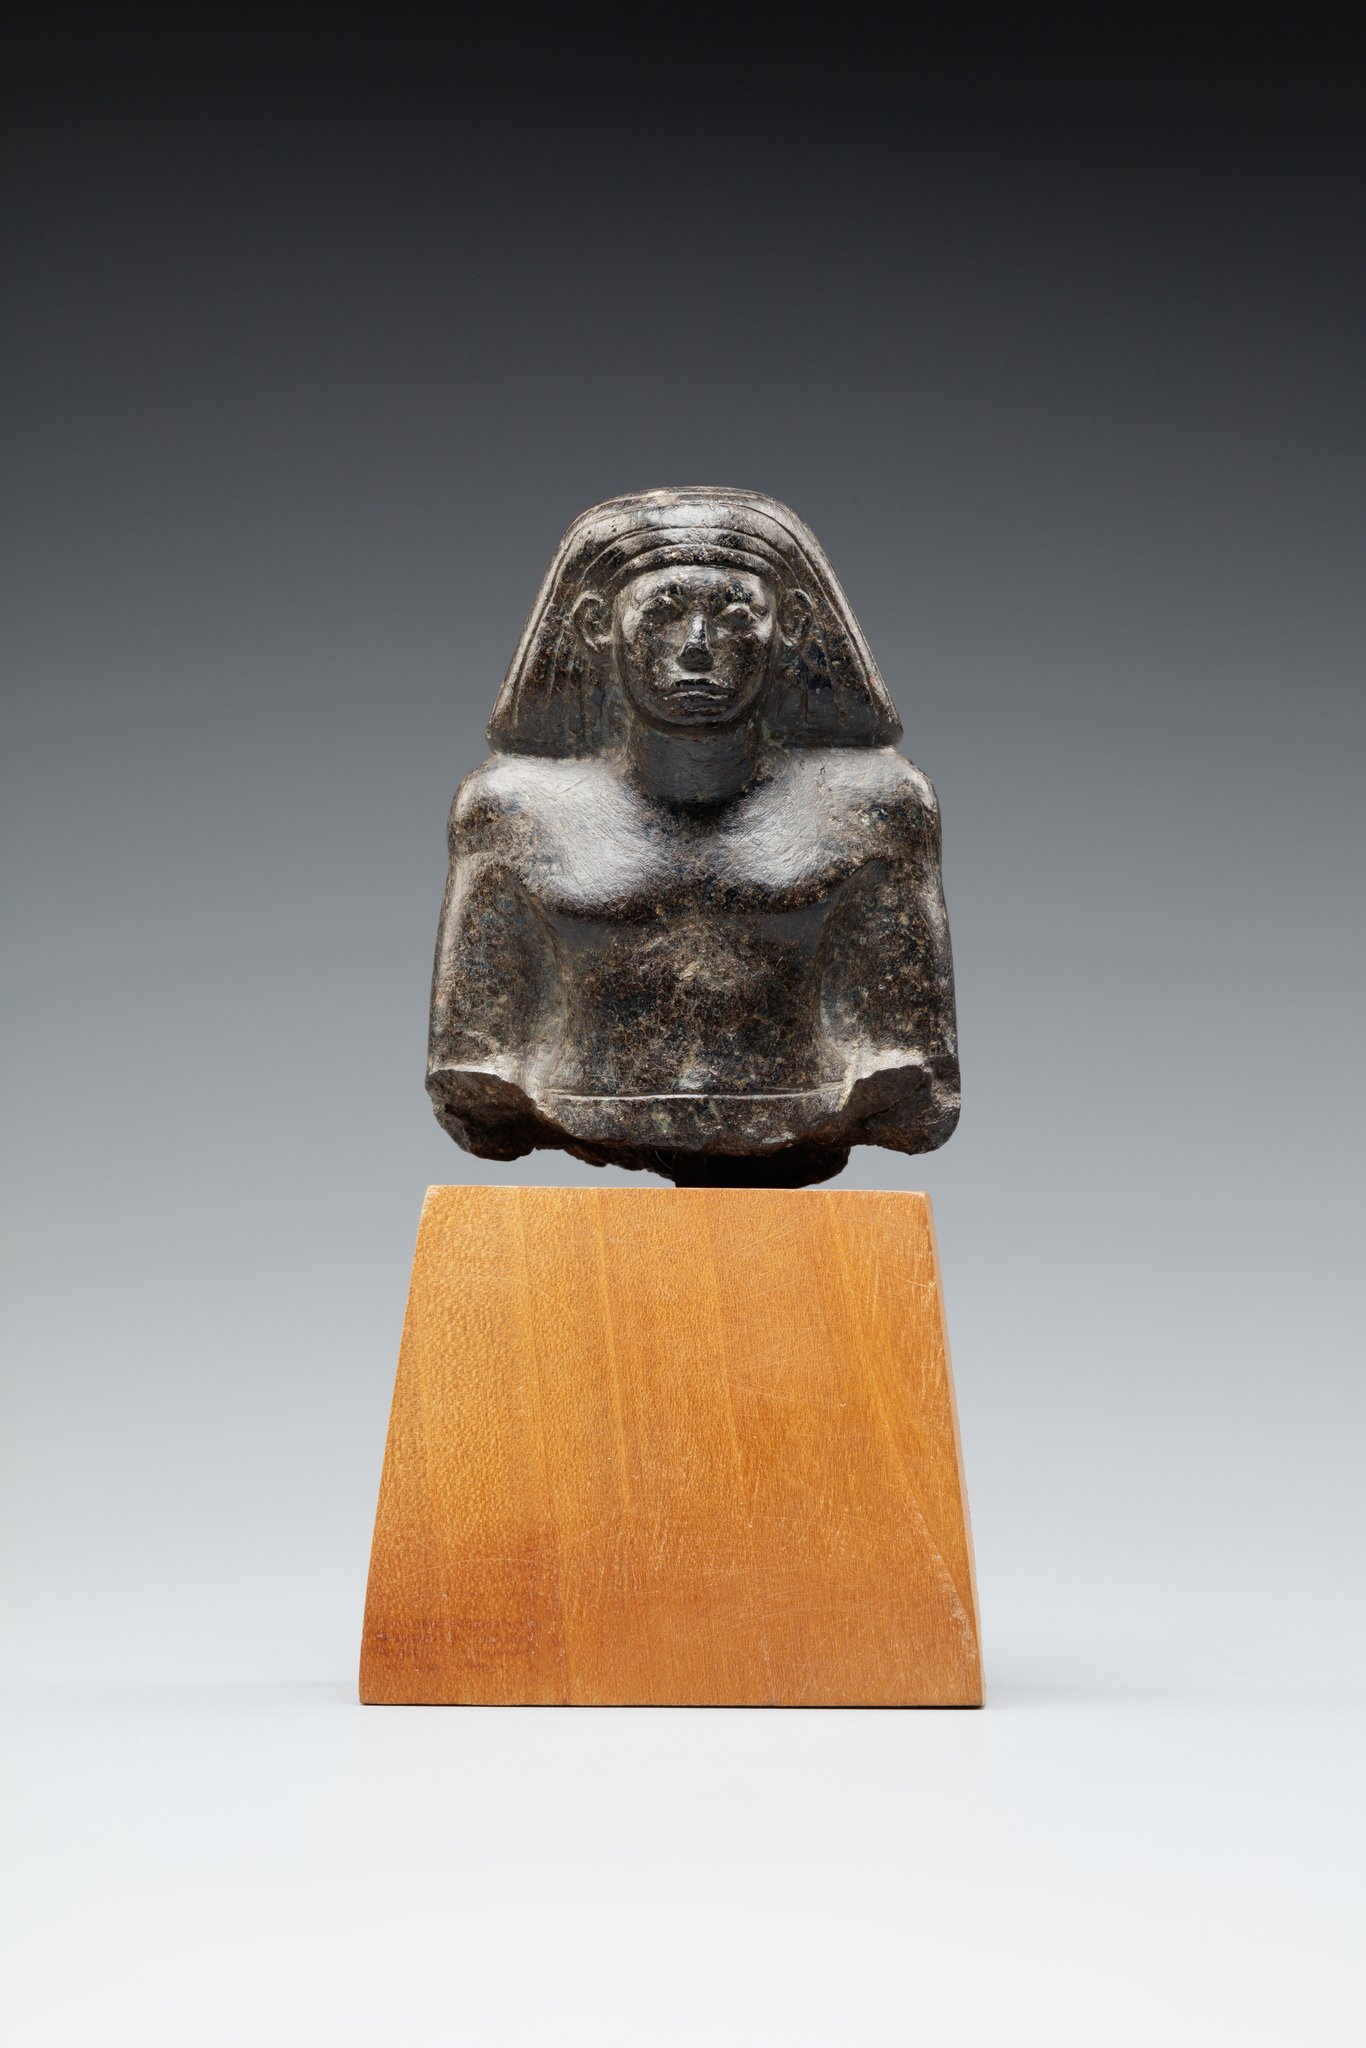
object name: upper part of a figure of a seated official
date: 1850-1800 BCE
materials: stone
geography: egypt